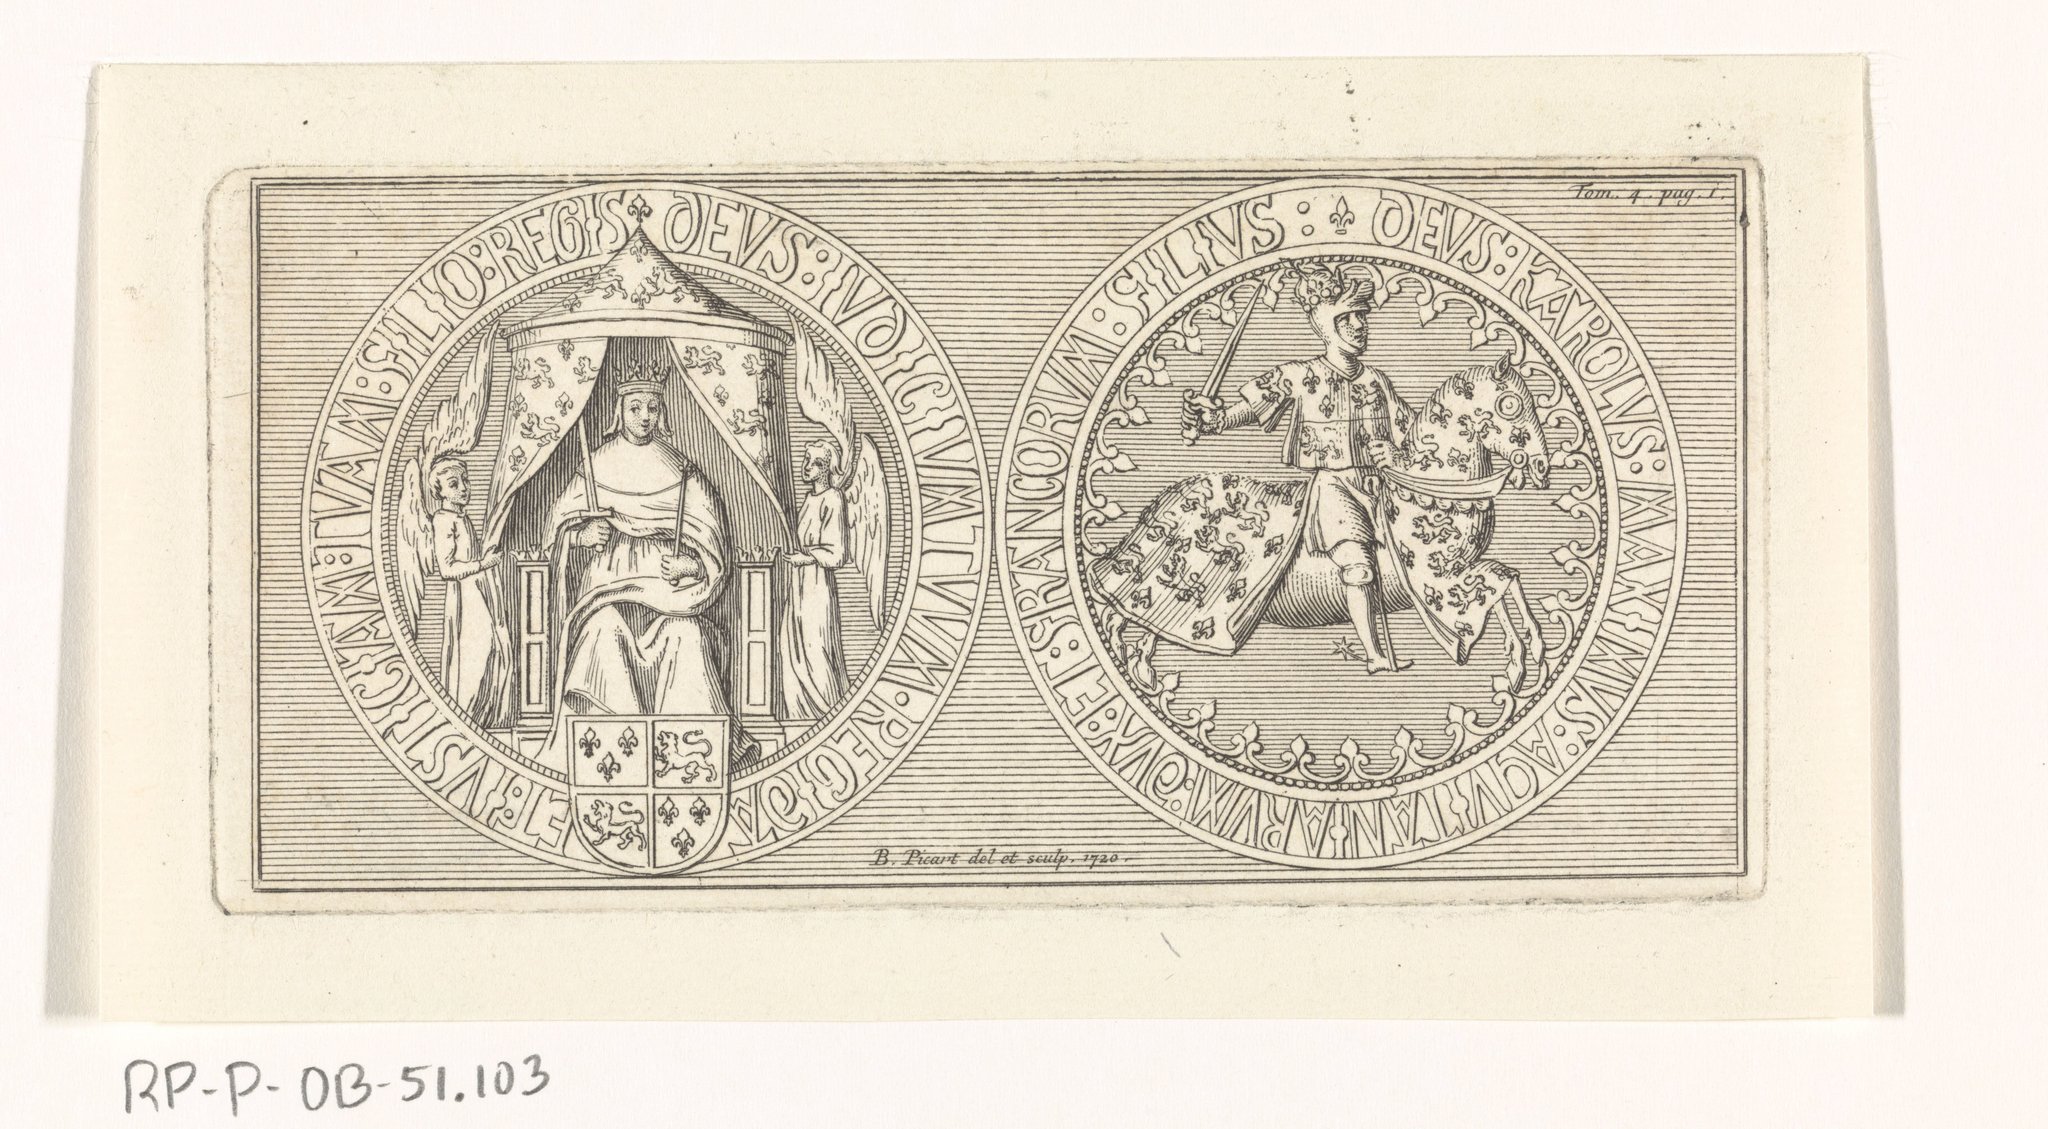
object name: book illustration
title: Penning met het portret van Karel de Grote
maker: bernard picart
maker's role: draughtsman, print maker, publisher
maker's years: 1673-1733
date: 1720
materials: paper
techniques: engraving, etching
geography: amsterdam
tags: charlemagne (holy roman emperor), throne, medal (considered as a piece of sculpture, regardless of its specific function), knight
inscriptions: collector's mark: Lugt 2228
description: Penning met het portret van Karel de Grote, Rooms keizer, op een troon, geflankeerd door engelen. Op de andere zijde Karel de Grote als ridder te paard.